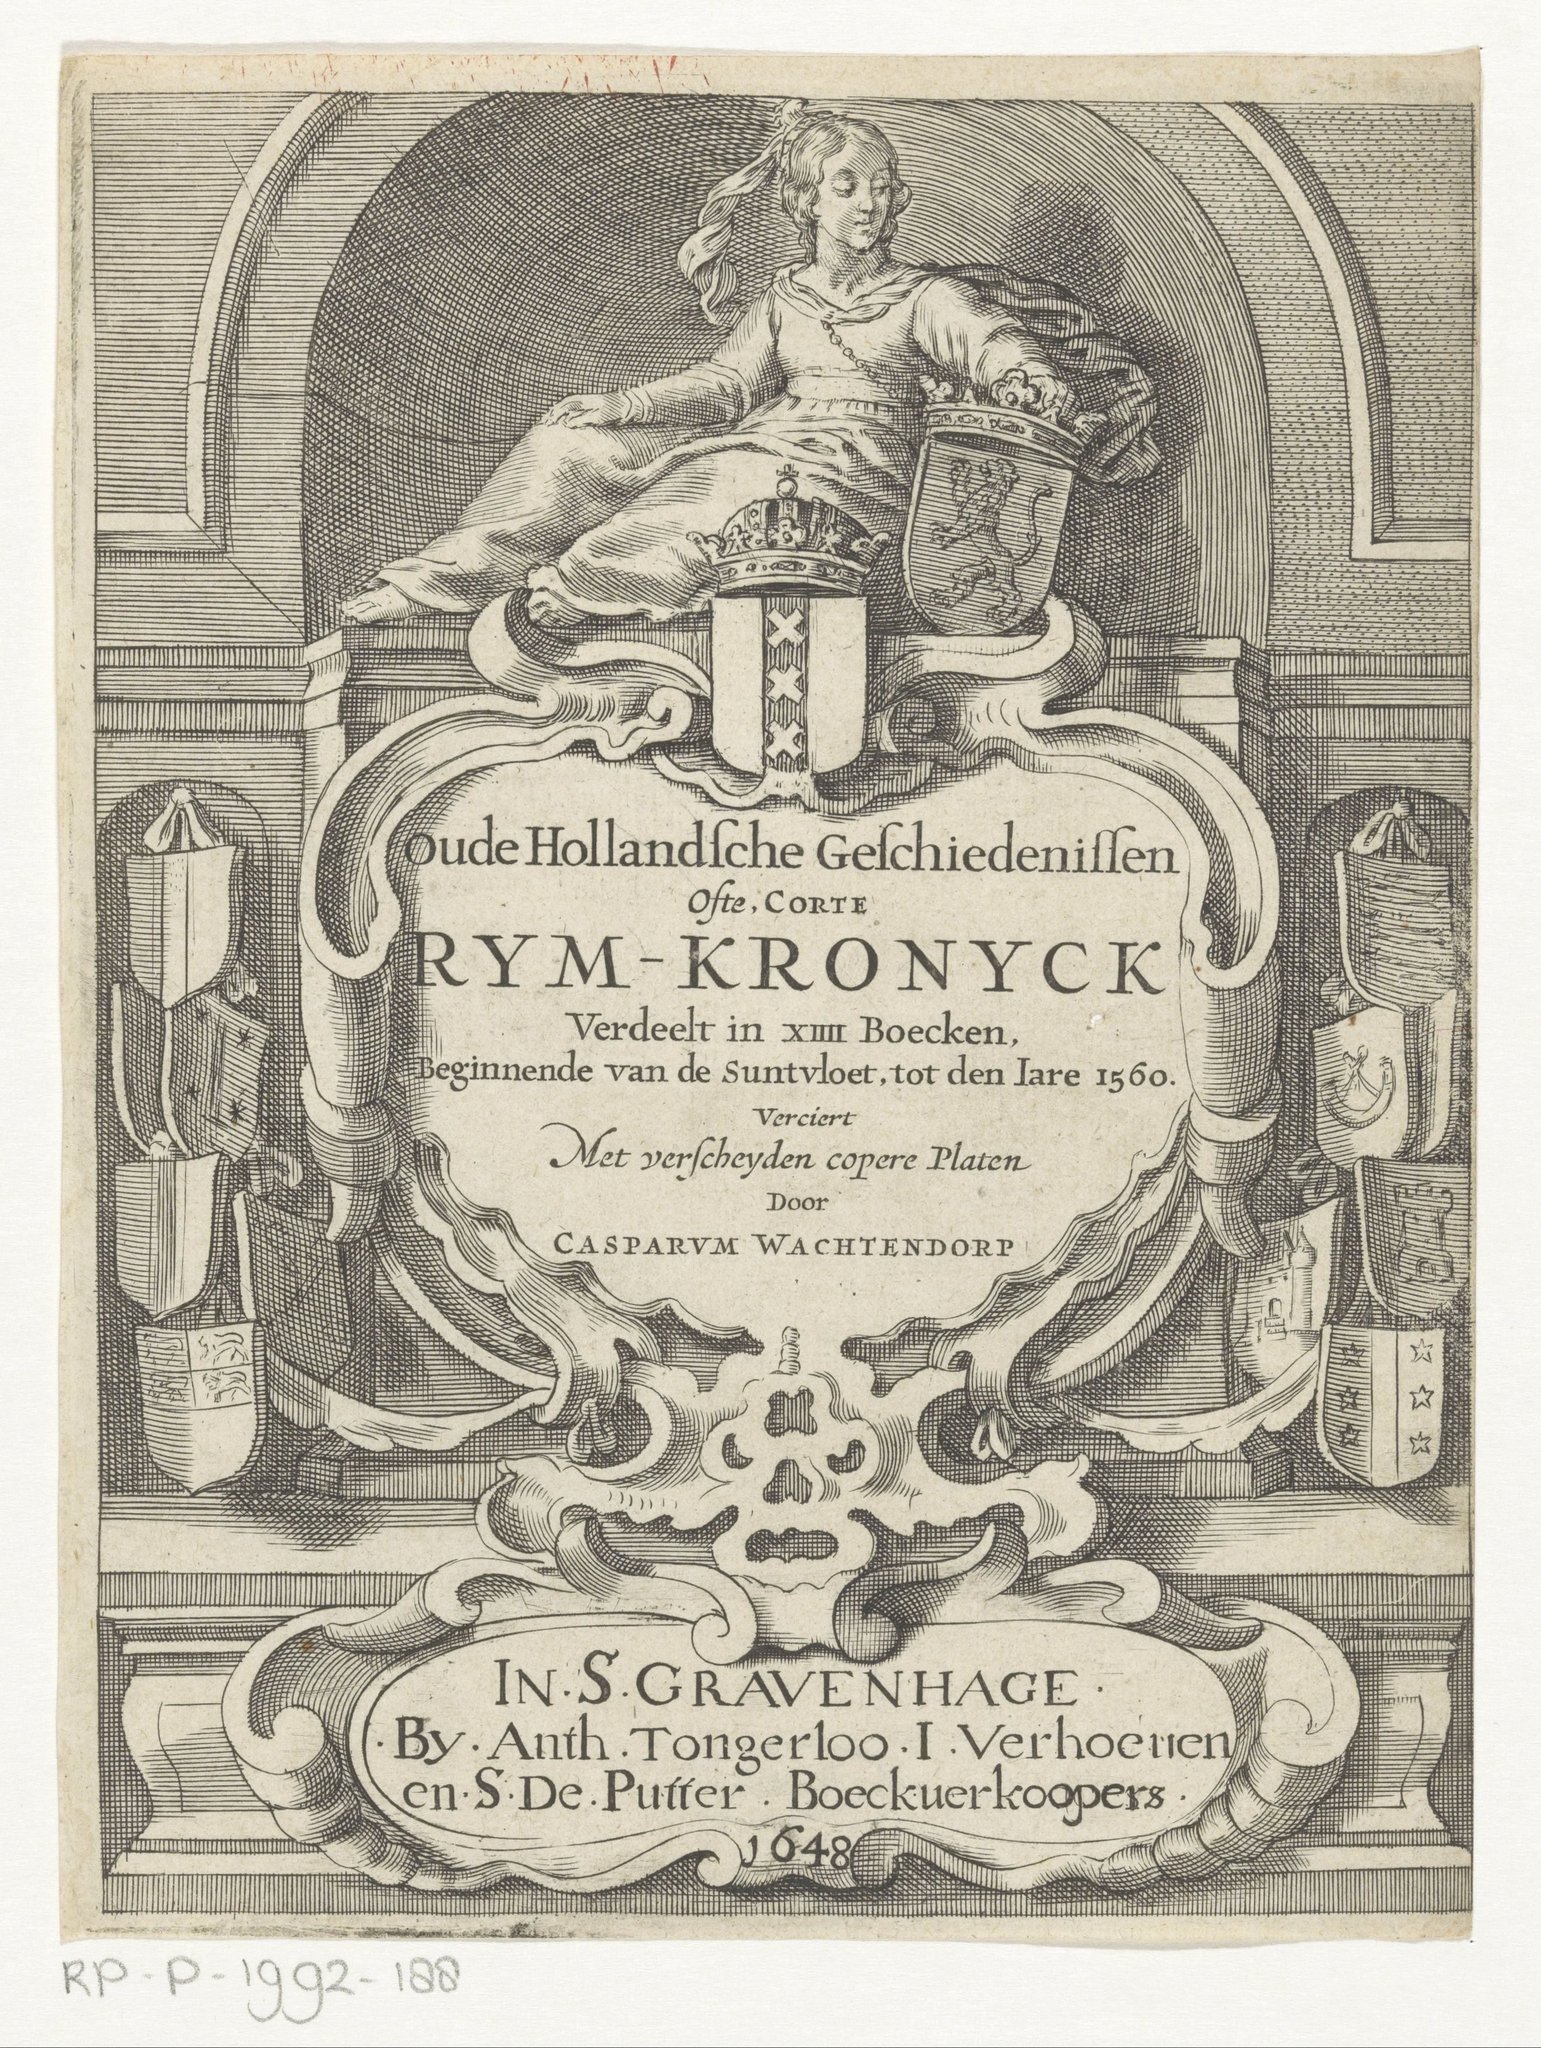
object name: titelblad, titelpagina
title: Titelpagina voor: Caspar Wachtendorp, Oude Hollandsche Geschiedenissen Ofte, corte Rym-kronyck (...), 1648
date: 1648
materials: paper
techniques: engraving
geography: the hague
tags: coat of arms (as symbol of the state, etc.), sitting figure - aa - female human figure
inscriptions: collector's mark: Lugt 2228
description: Een allegorische vrouwenfiguur zit met het wapen van de Nederlanden boven een rocaille cartouche met titel en het wapen van Amsterdam. Links en rechts twaalf wapenschilden.